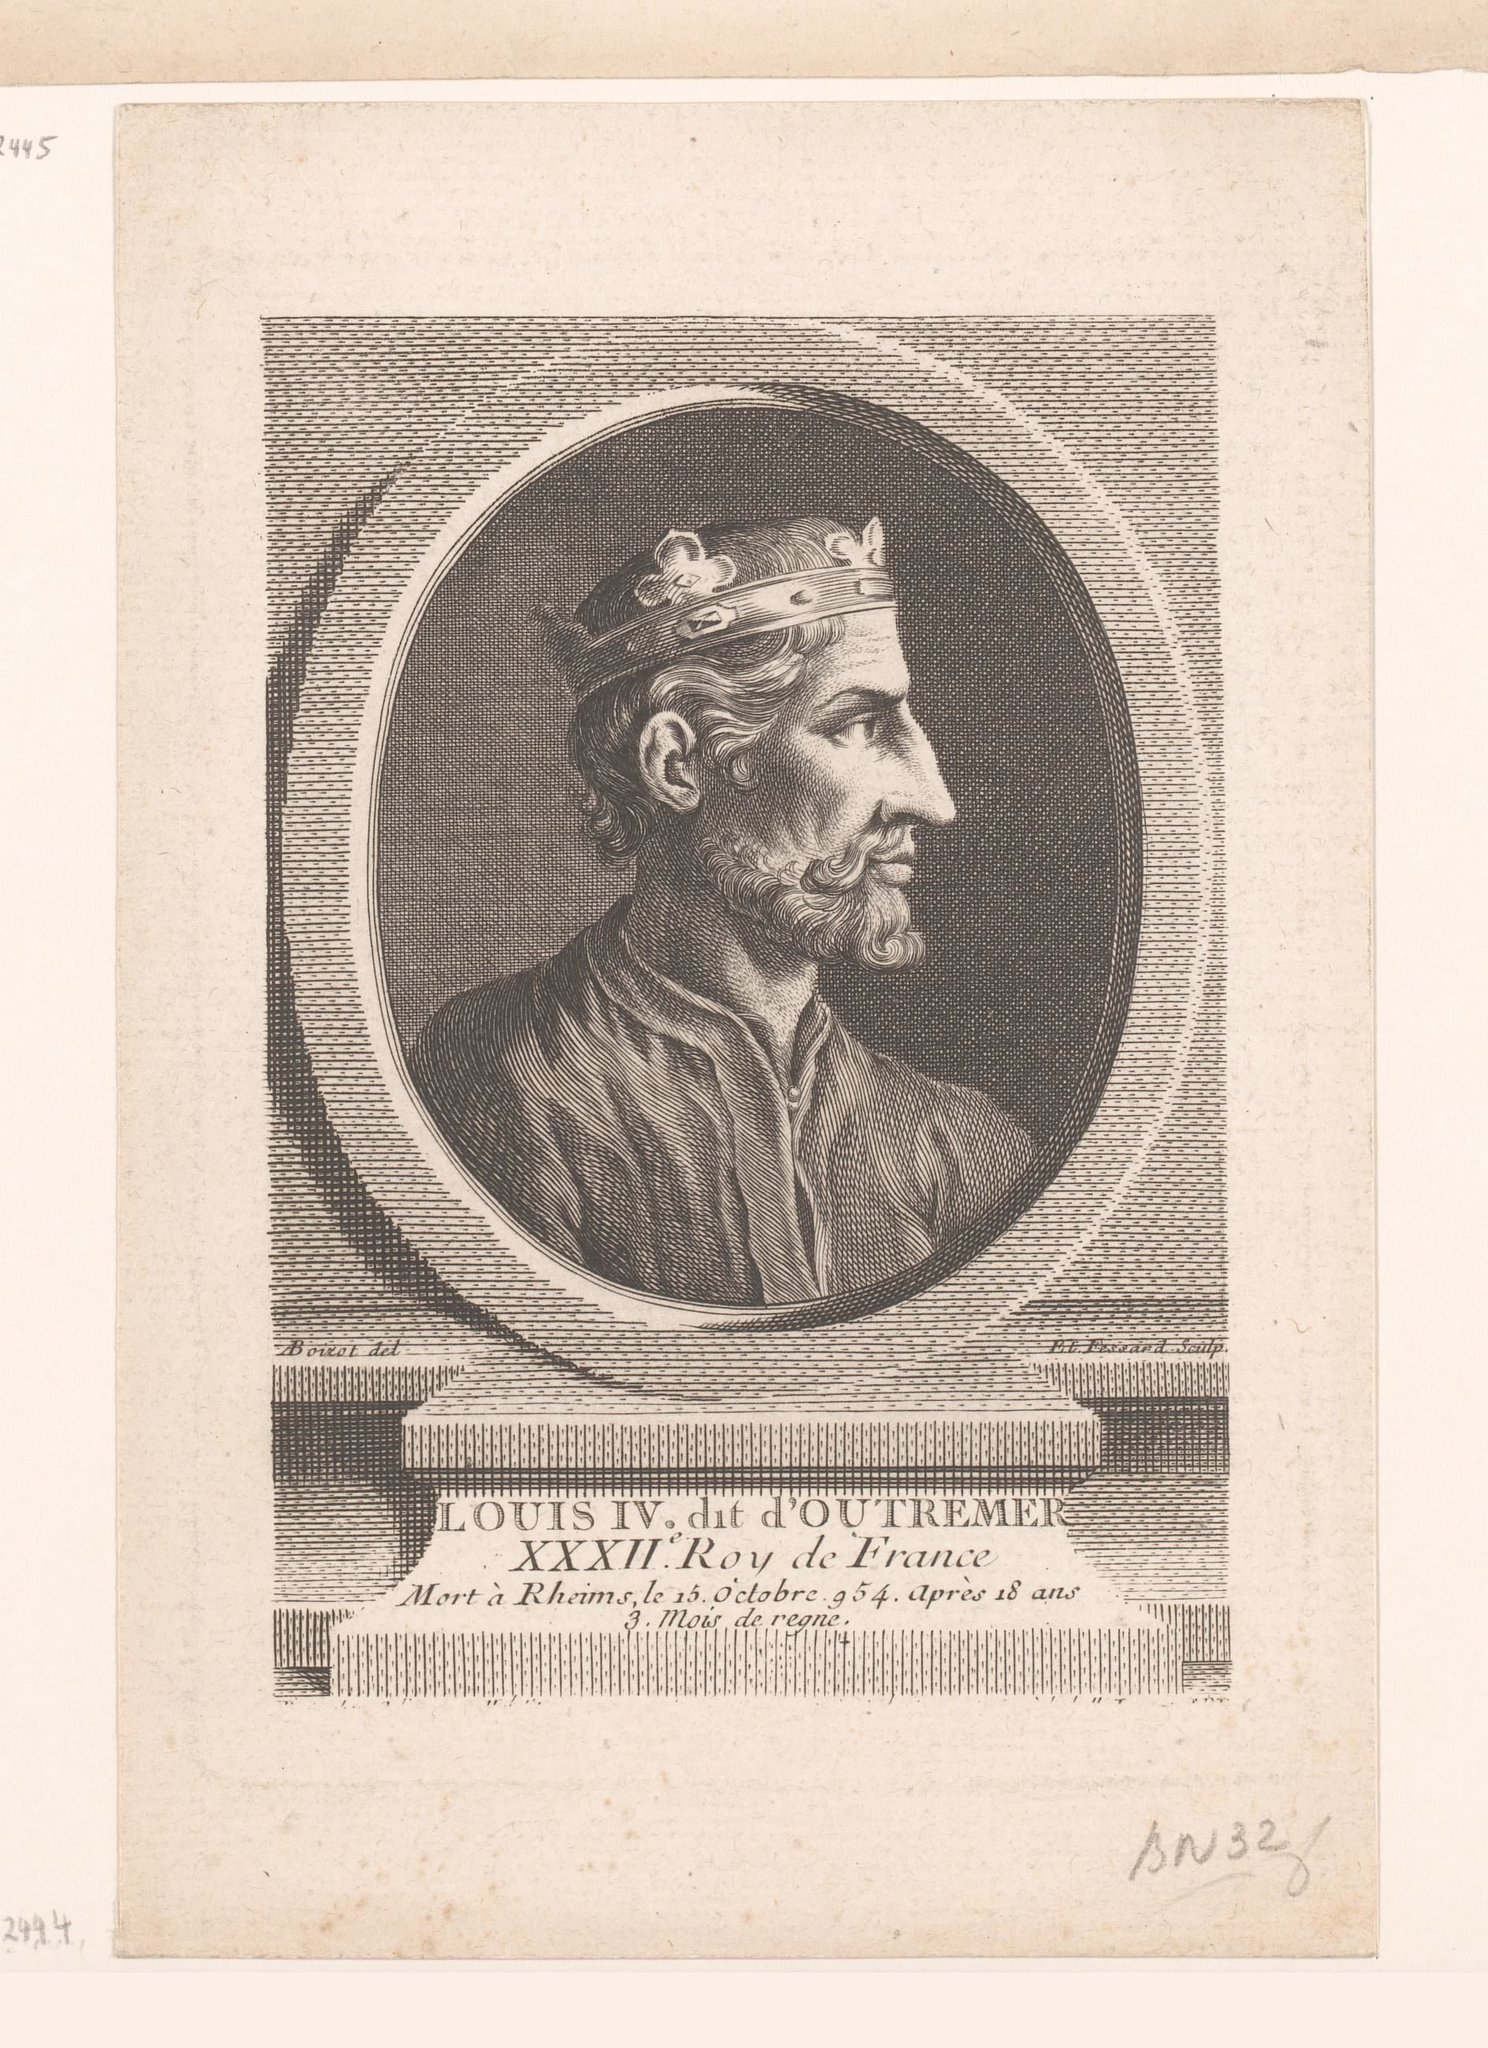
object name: print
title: Louis IV. dit d'Outremer XXXIIe. Roi de France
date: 1741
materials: paper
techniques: engraving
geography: france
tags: london, ornament ~ medallion, historical persons, ruler, sovereign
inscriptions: collector's mark: Lugt 2228